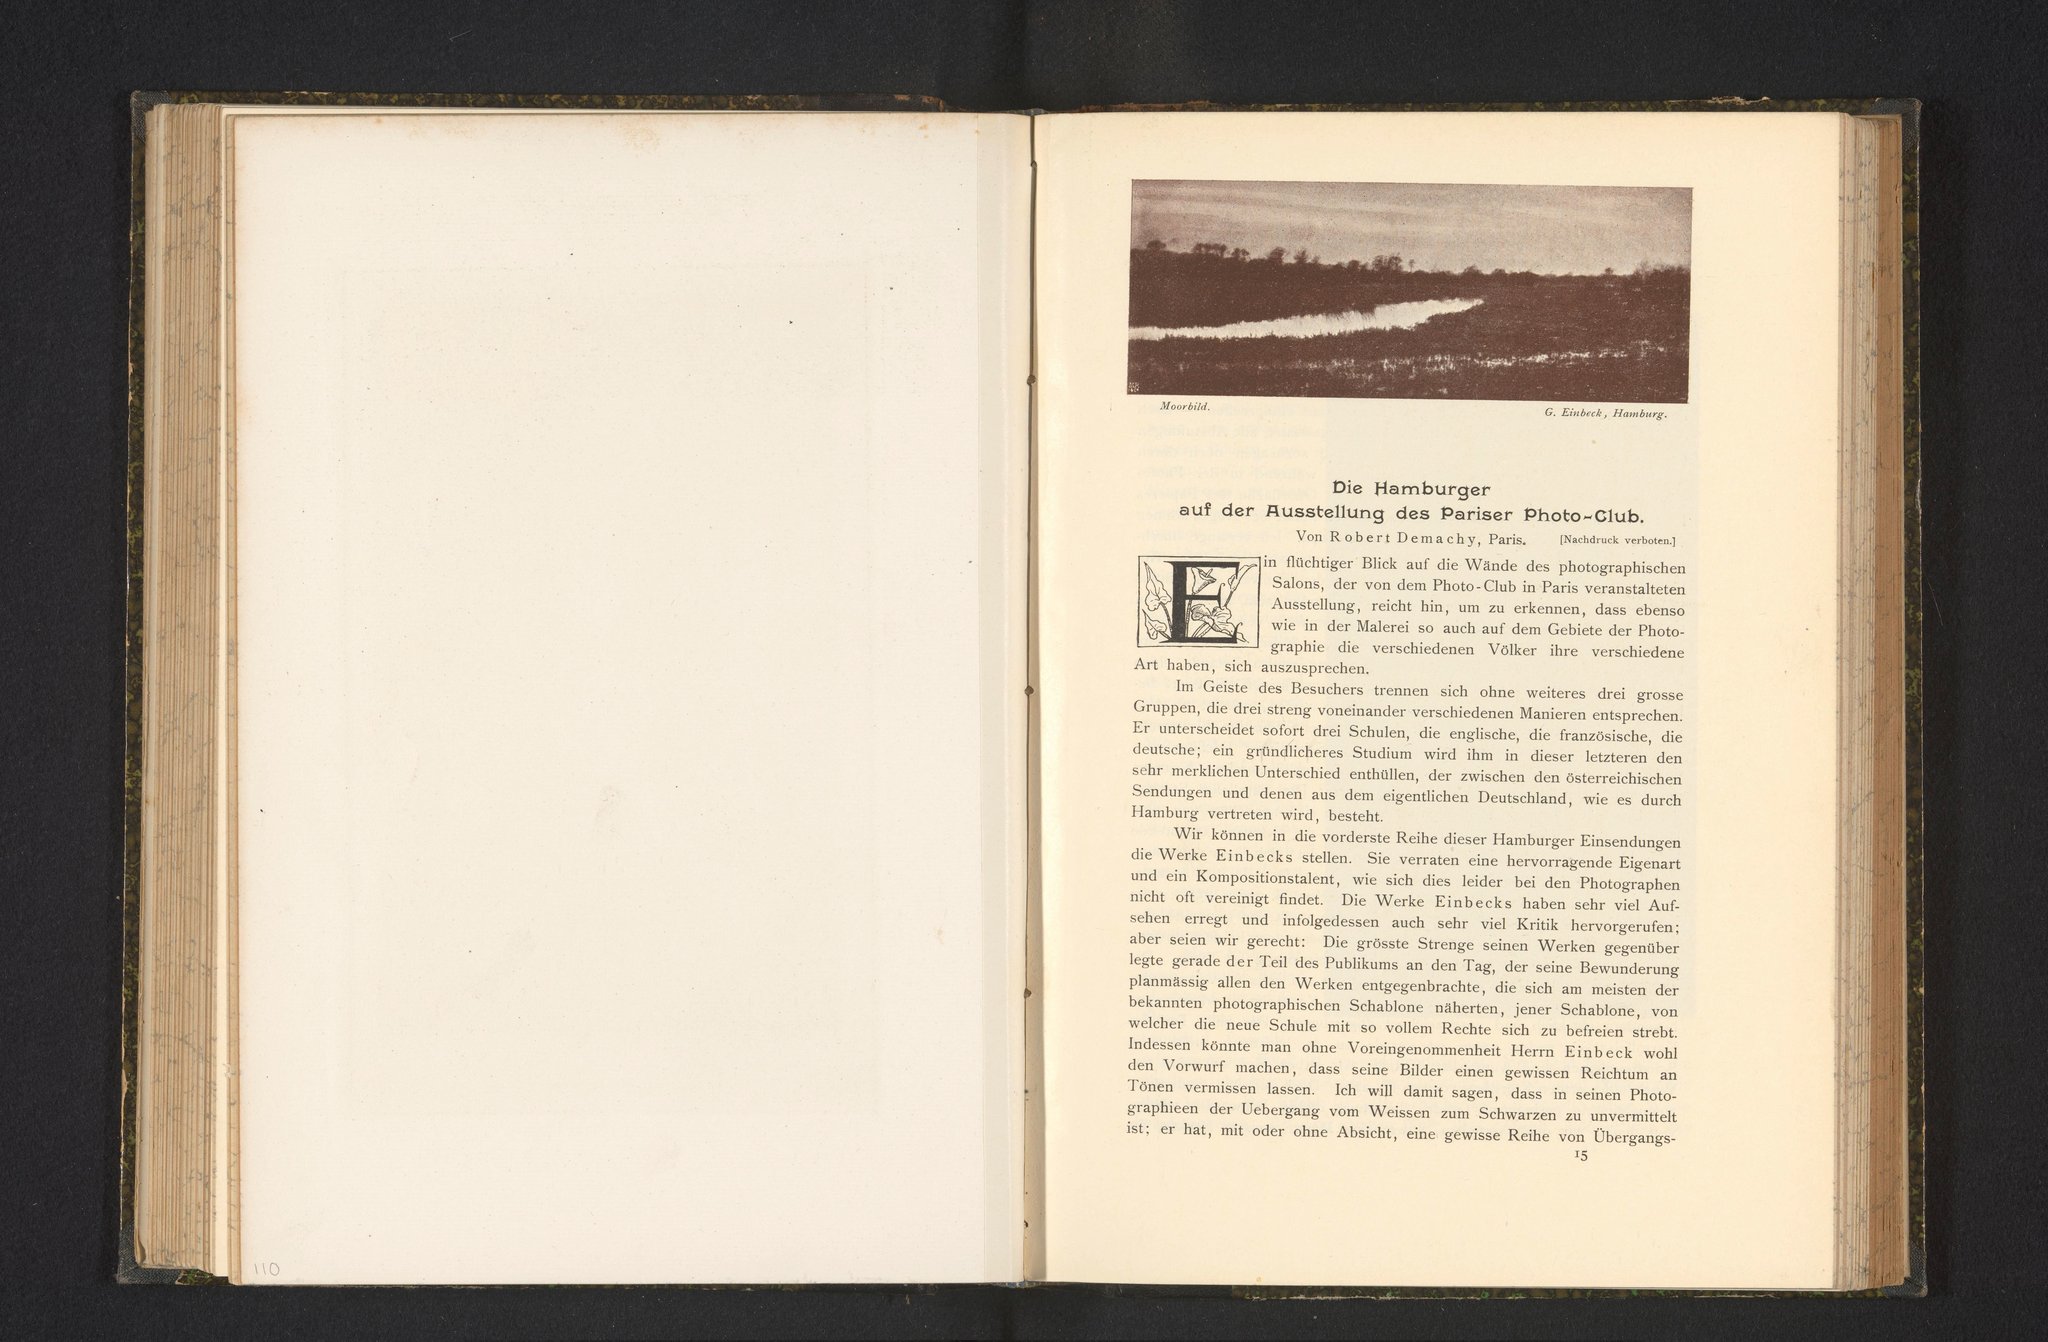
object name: page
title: Moorbild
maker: george einbeck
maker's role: painter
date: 1893-1898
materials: paper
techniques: autotype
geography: berlin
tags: landscapes with waters, waterscapes, seascapes (in the temperate zone)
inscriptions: monogram: ‘MR/ &Co’